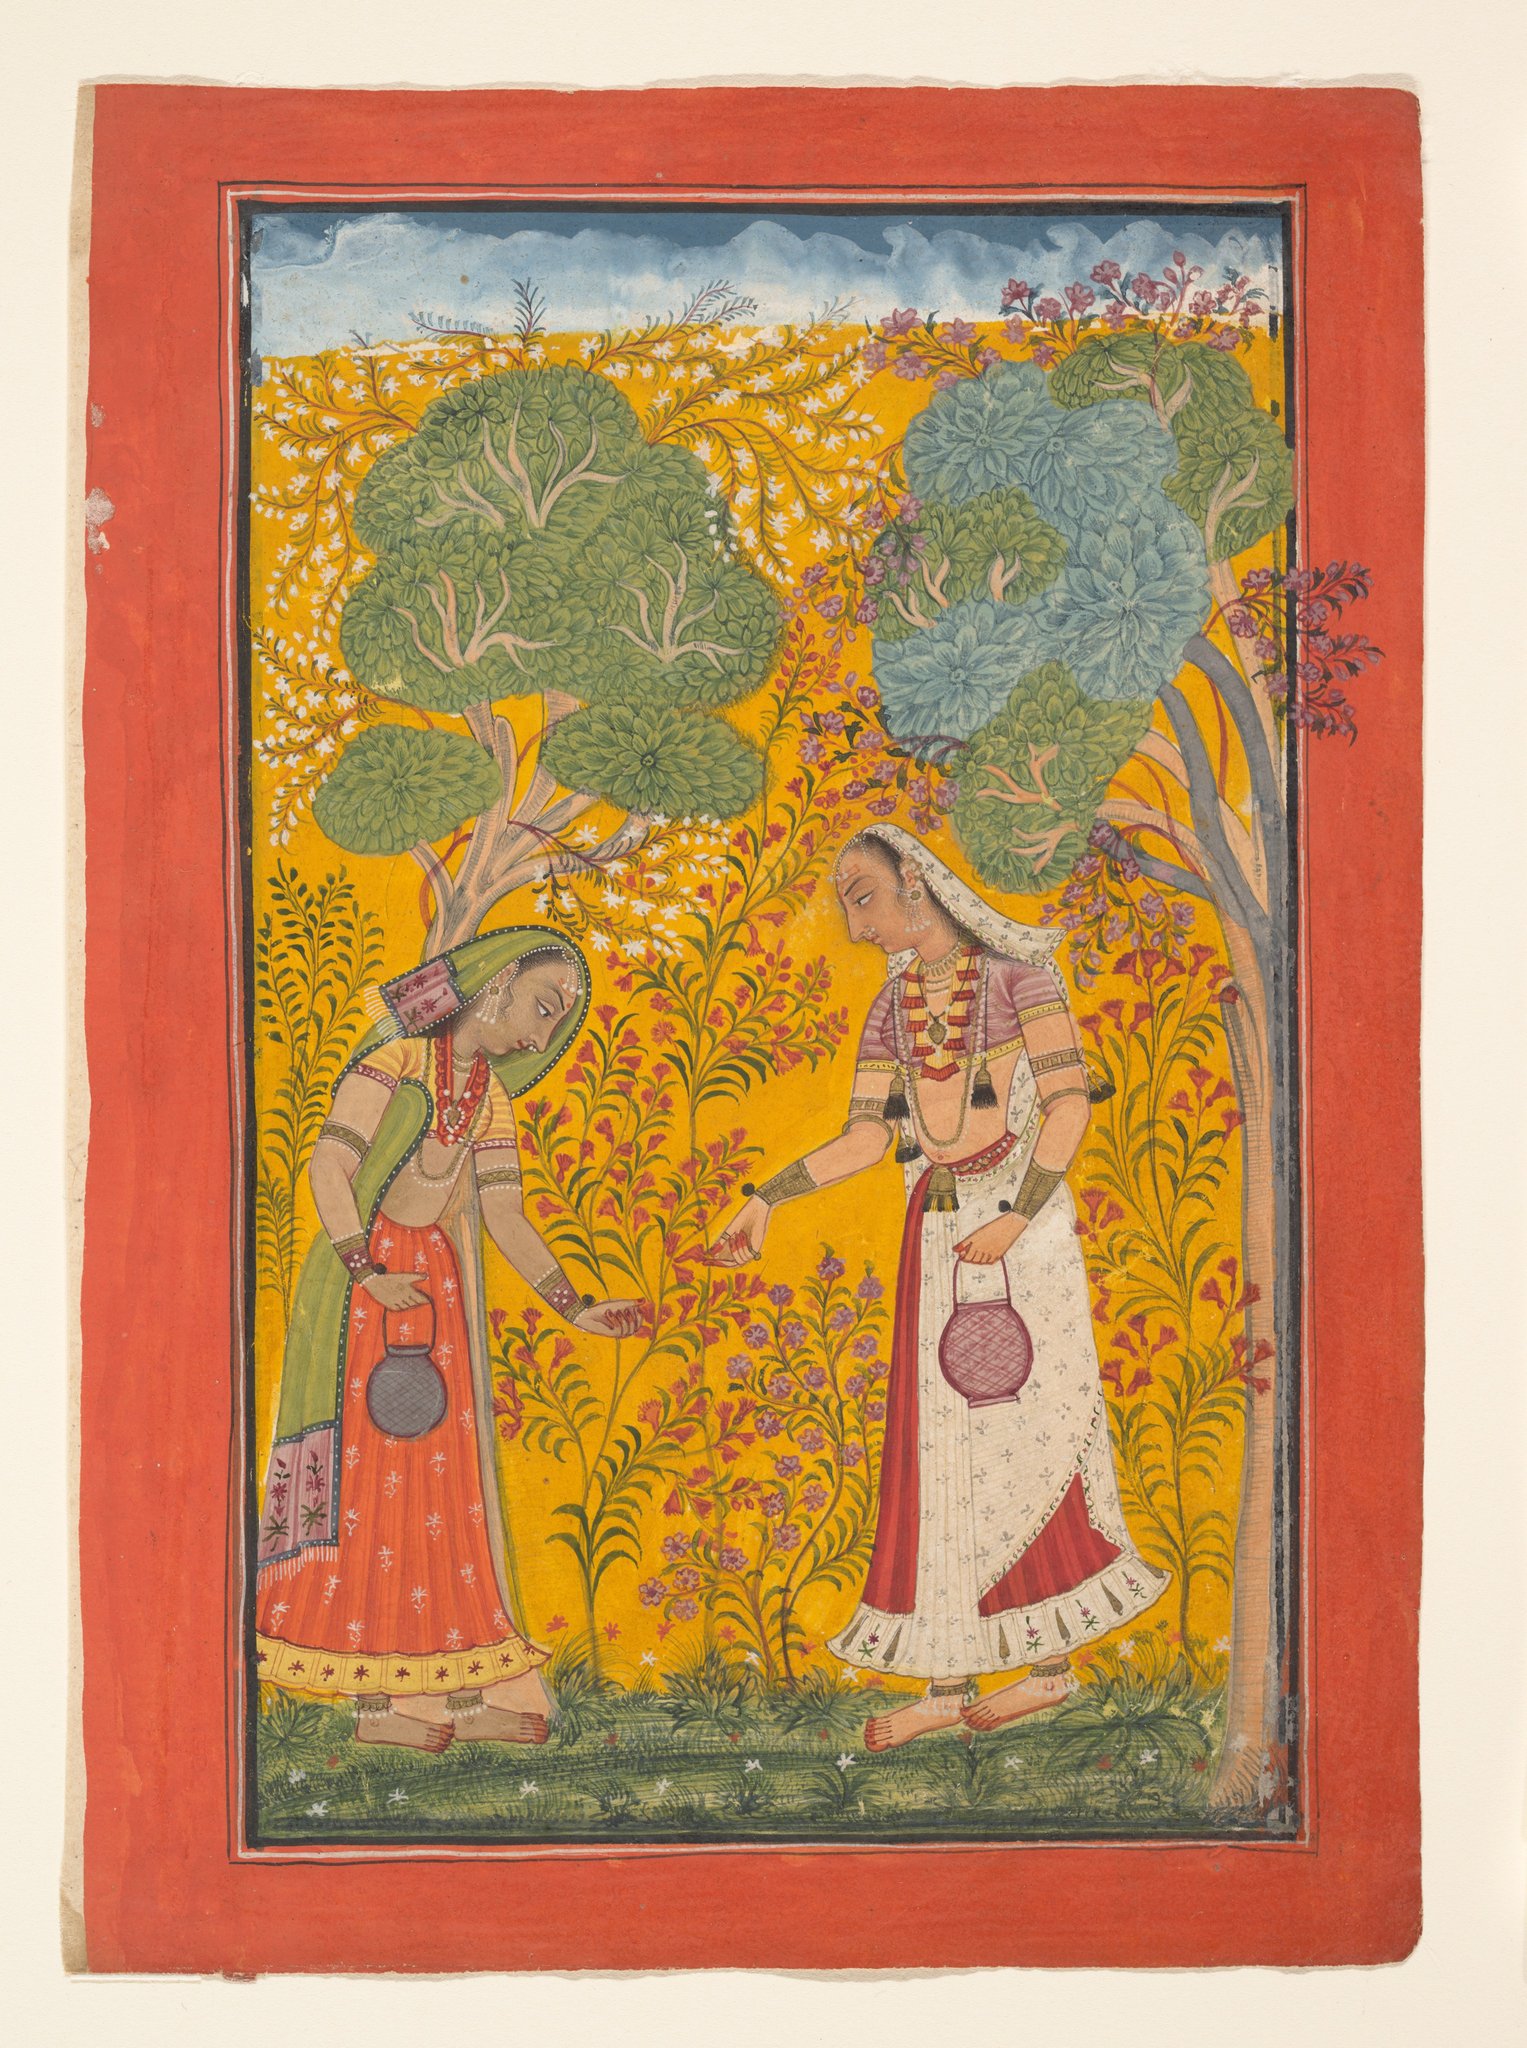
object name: page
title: Vasanti Ragini, Page from a Ragamala Series (Garland of Musical Modes)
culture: indian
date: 1710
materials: gold, ink, paper, watercolor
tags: women,flowers,trees,baskets